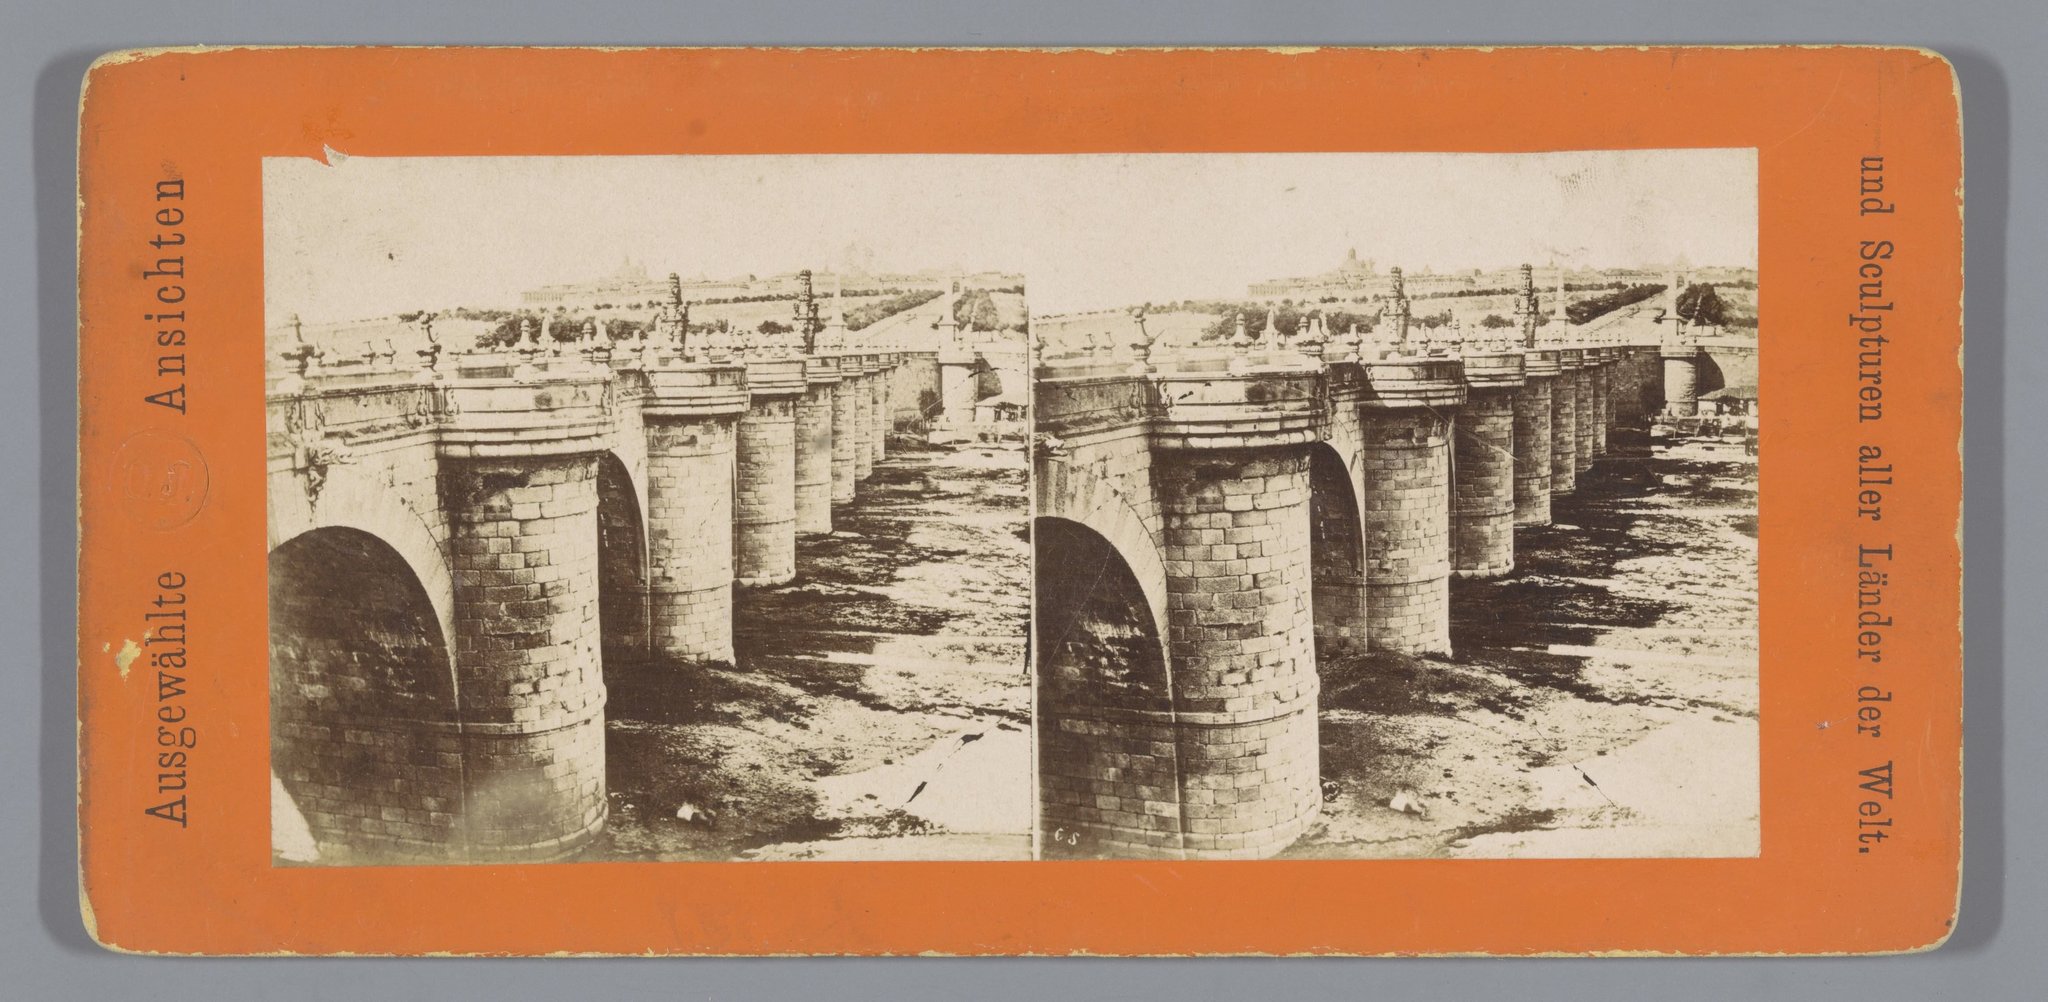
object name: stereograph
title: Gezicht op de Puente de Toledo te Madrid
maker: Anonymous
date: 1850-1880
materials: cardboard, photographic support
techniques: albumen print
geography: madrid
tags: bridge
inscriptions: inscription: ‘Ausgewählte Ansichten und Sculpturen aller Länder der Welt.’, inscription: ‘Madrid die Toledobrücke’, number: ‘1050’